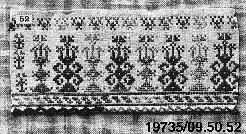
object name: textile fragment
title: Fragment of Border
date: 1801-1900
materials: linen, silk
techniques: embroidery, weave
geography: morocco